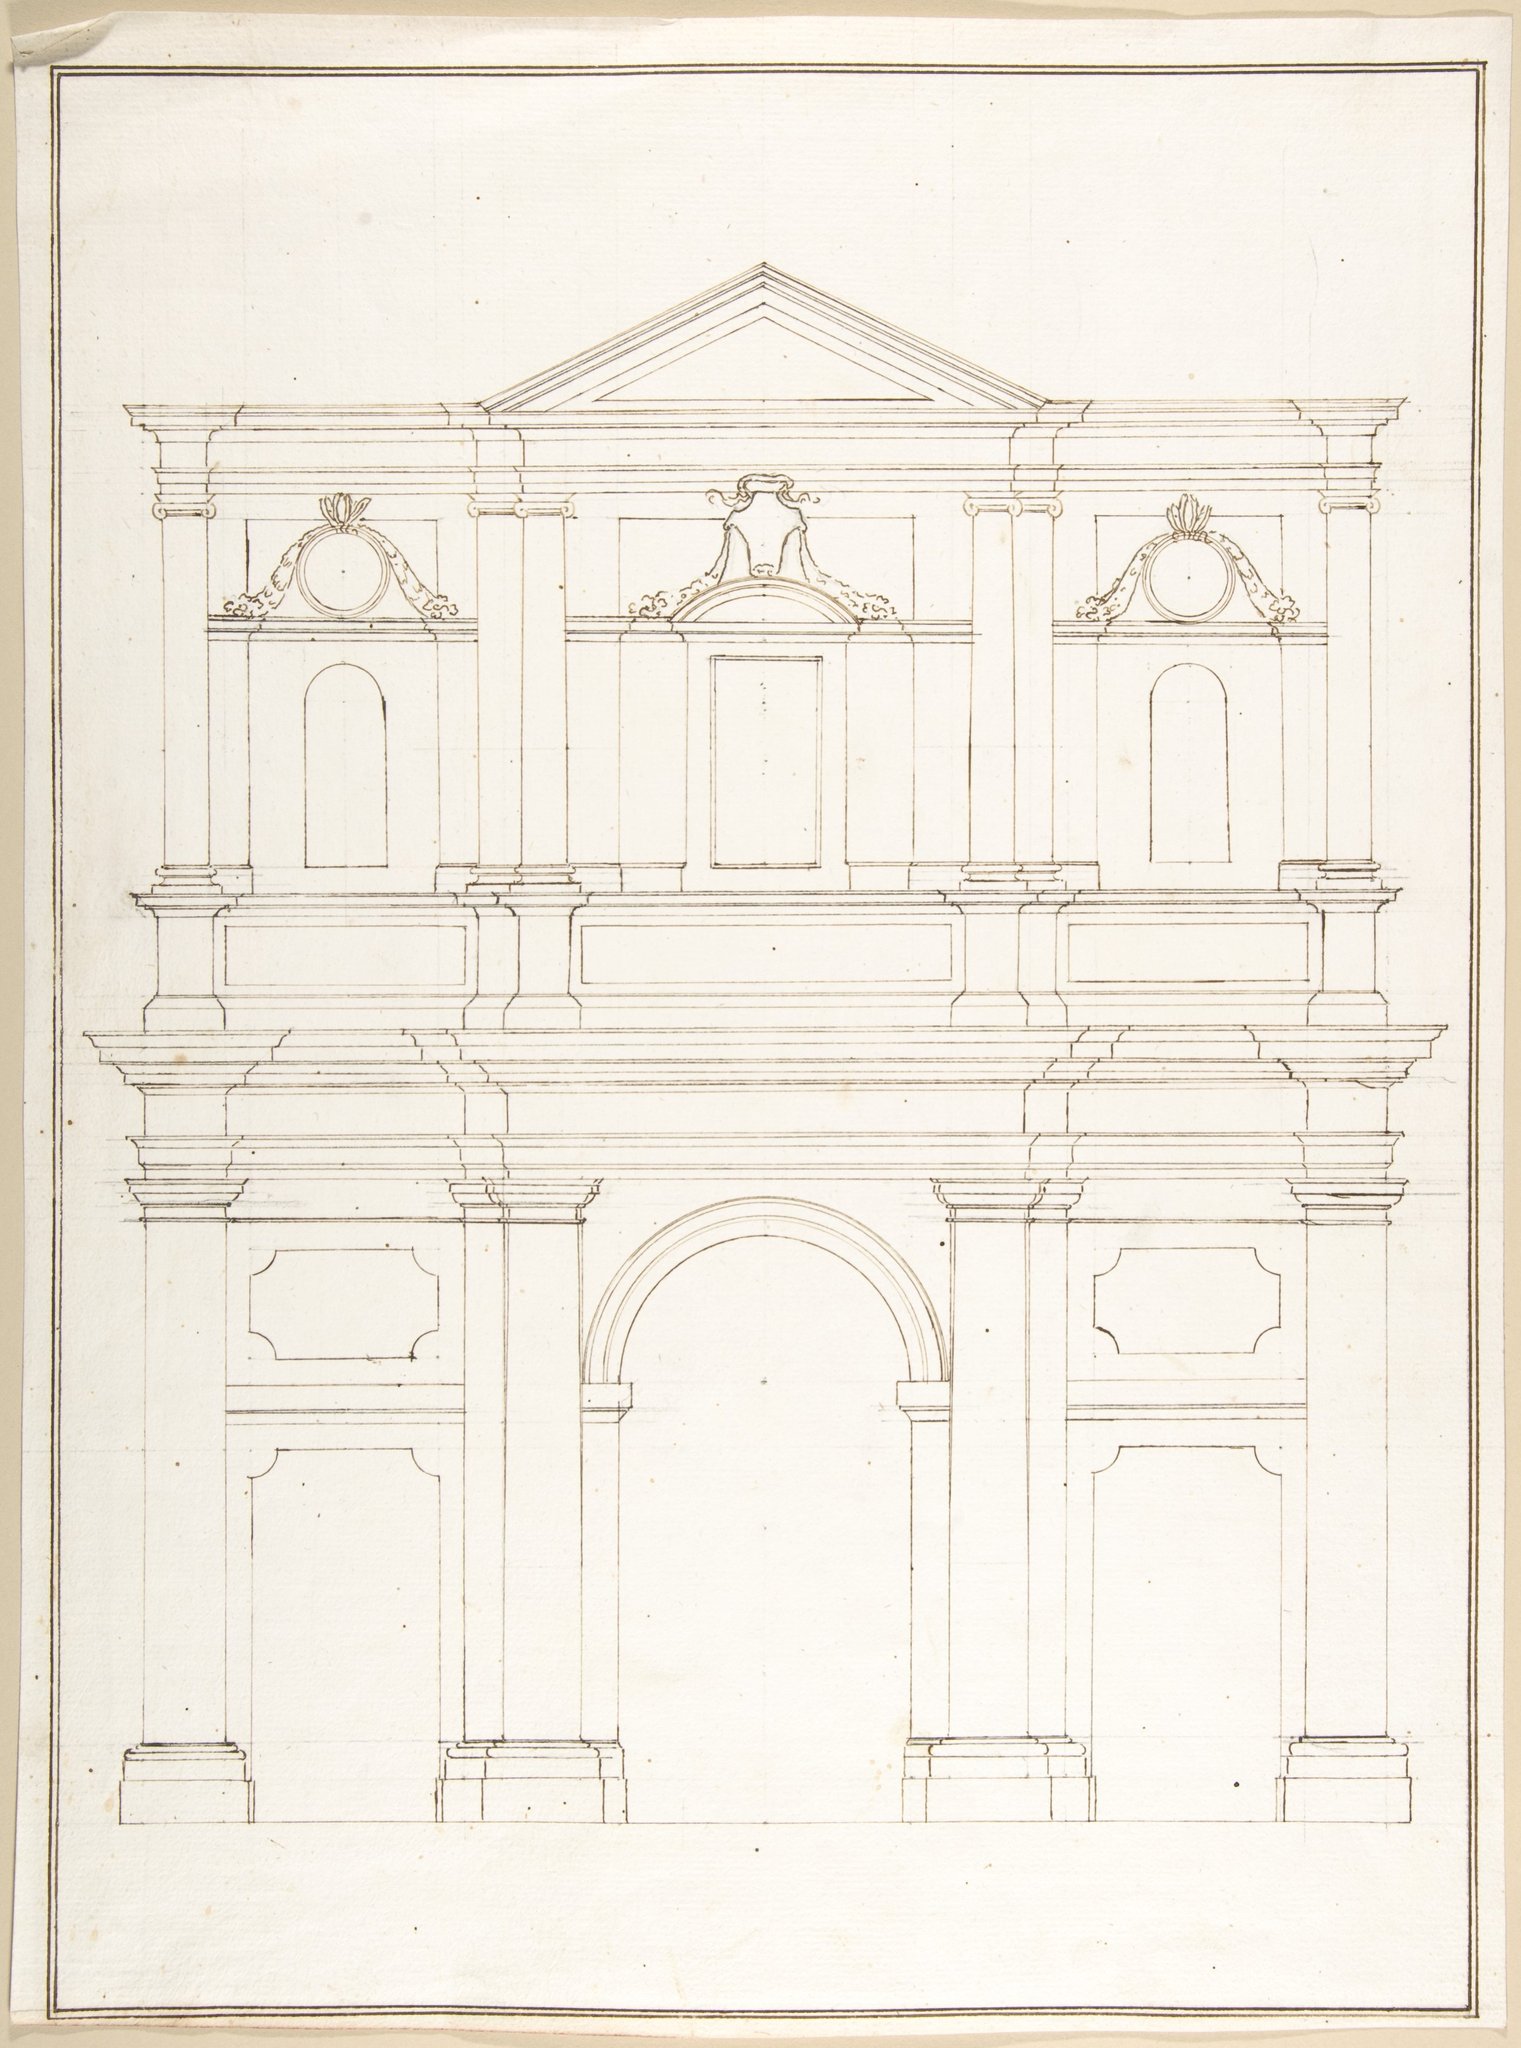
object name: drawing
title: Design for a Façade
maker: pietro paolo coccetti (cocchetti)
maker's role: artist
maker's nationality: italian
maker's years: 1710-1727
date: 1710-1727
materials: graphite, ink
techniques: pen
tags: architecture,buildings